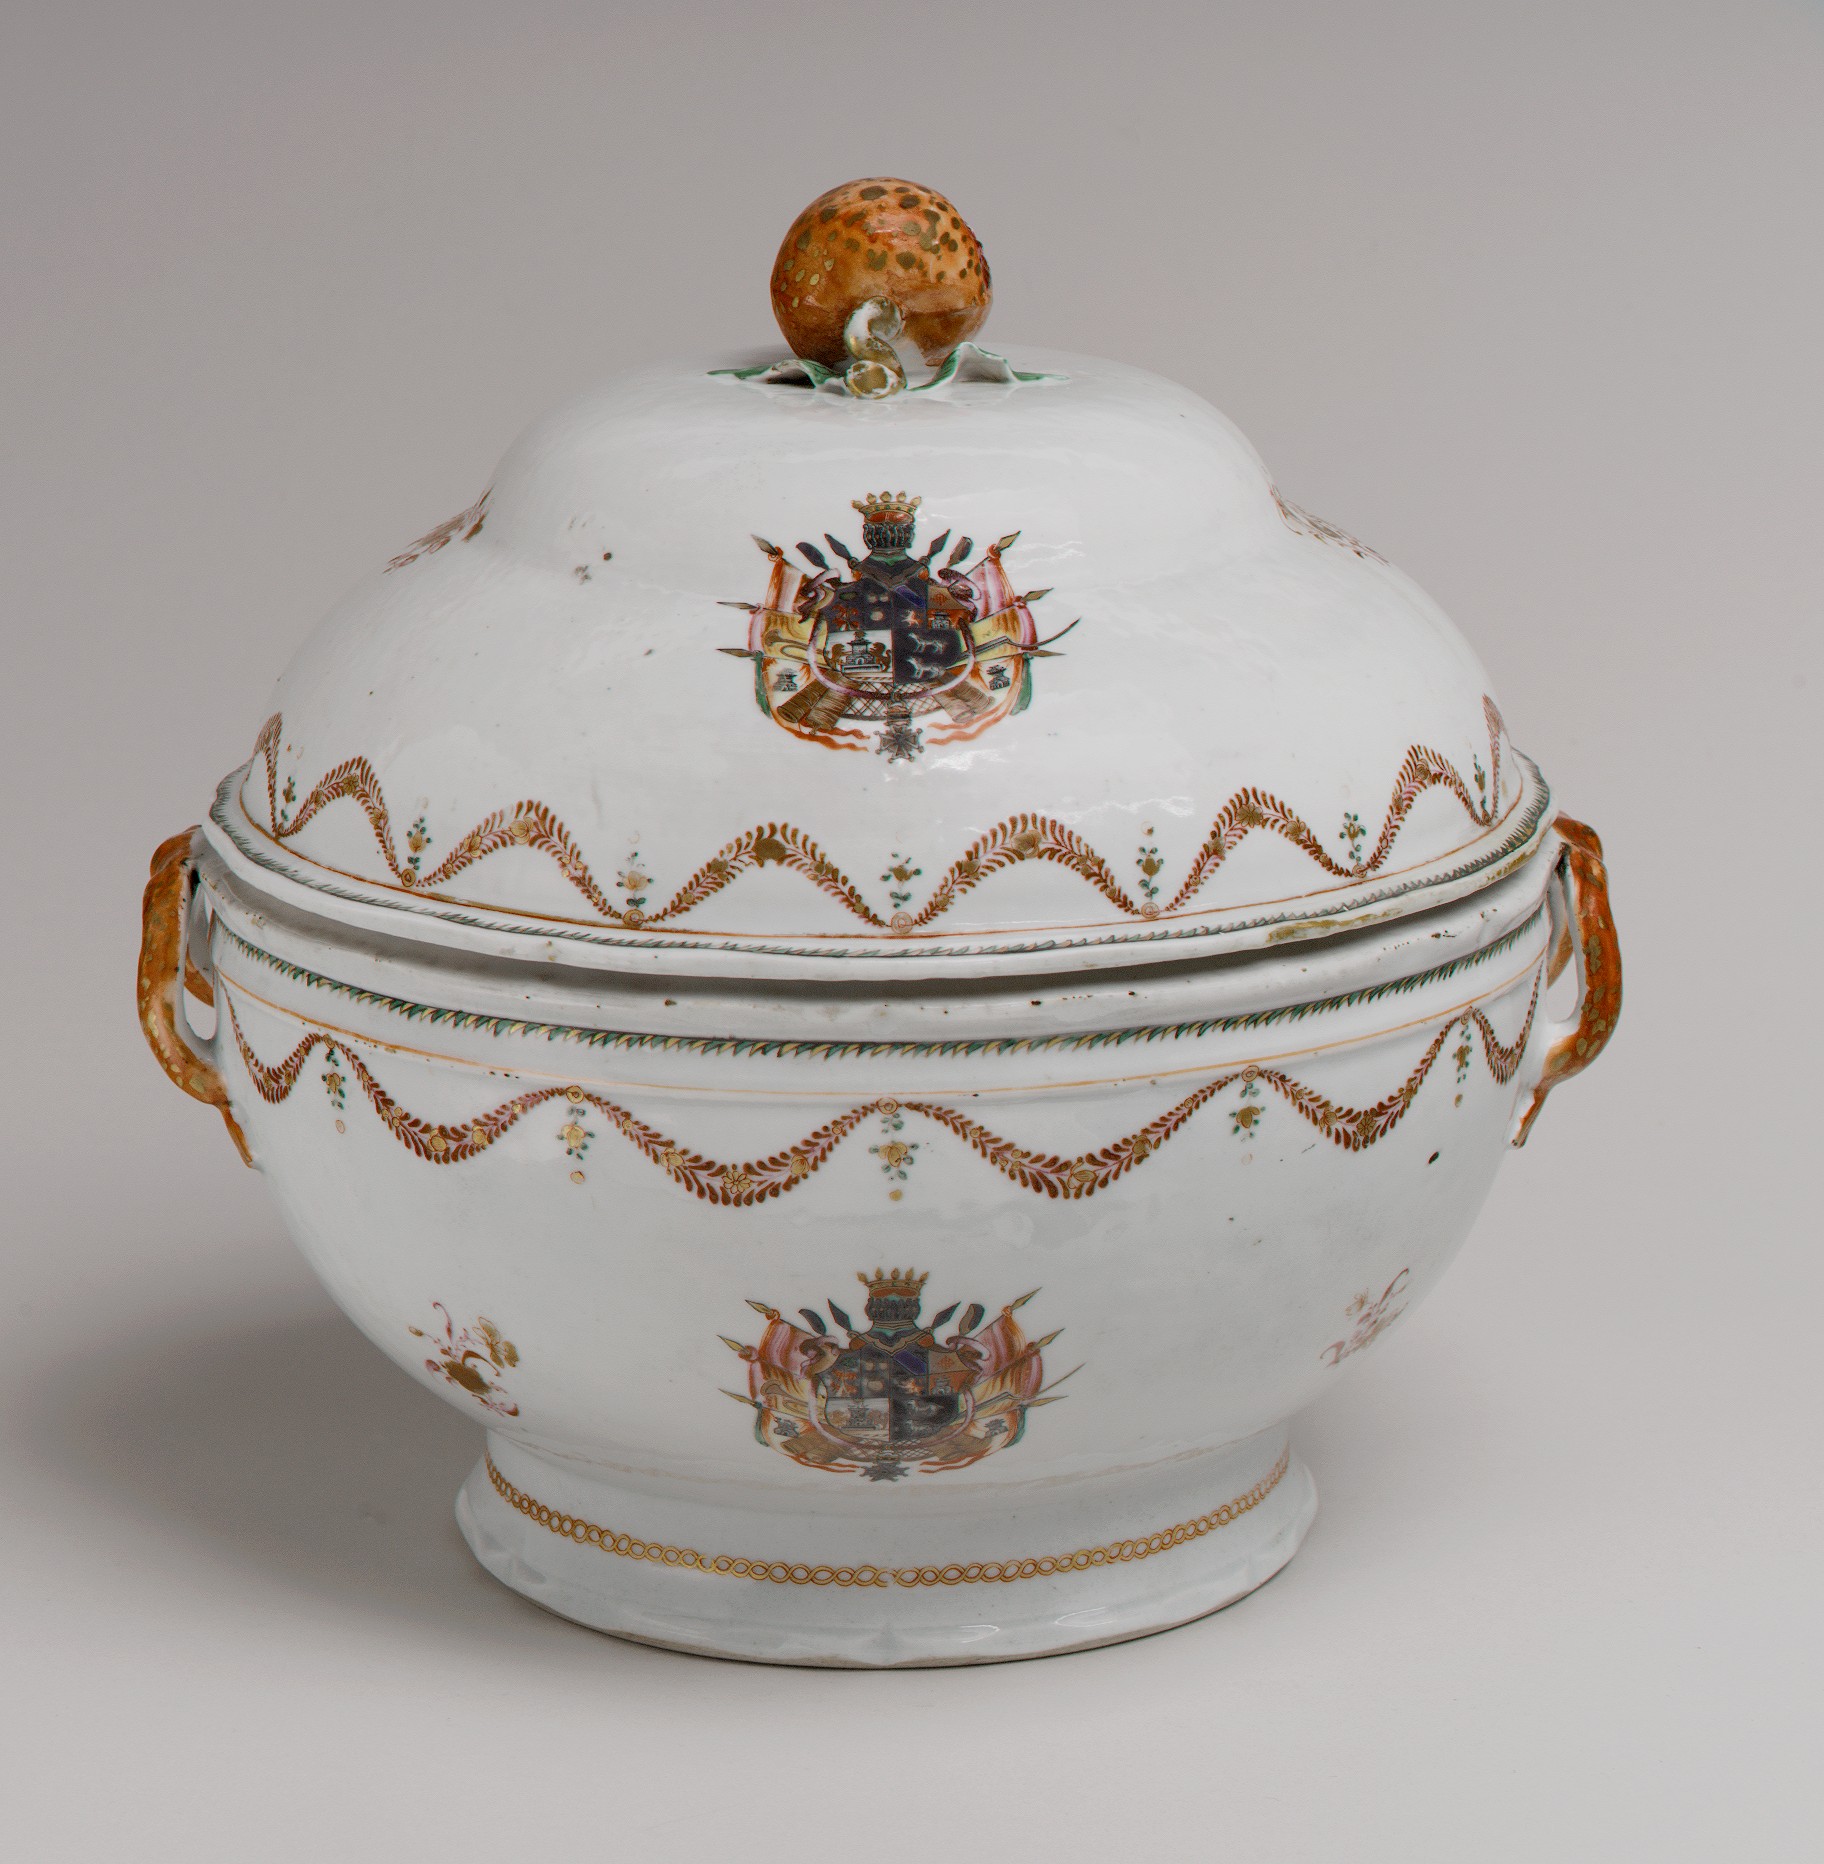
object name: tureen with cover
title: Tureen with the Coat-of-Arms of José de Gálvez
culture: chinese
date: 1783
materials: enamel, gilt, hard paste porcelain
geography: mexico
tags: coat of arms